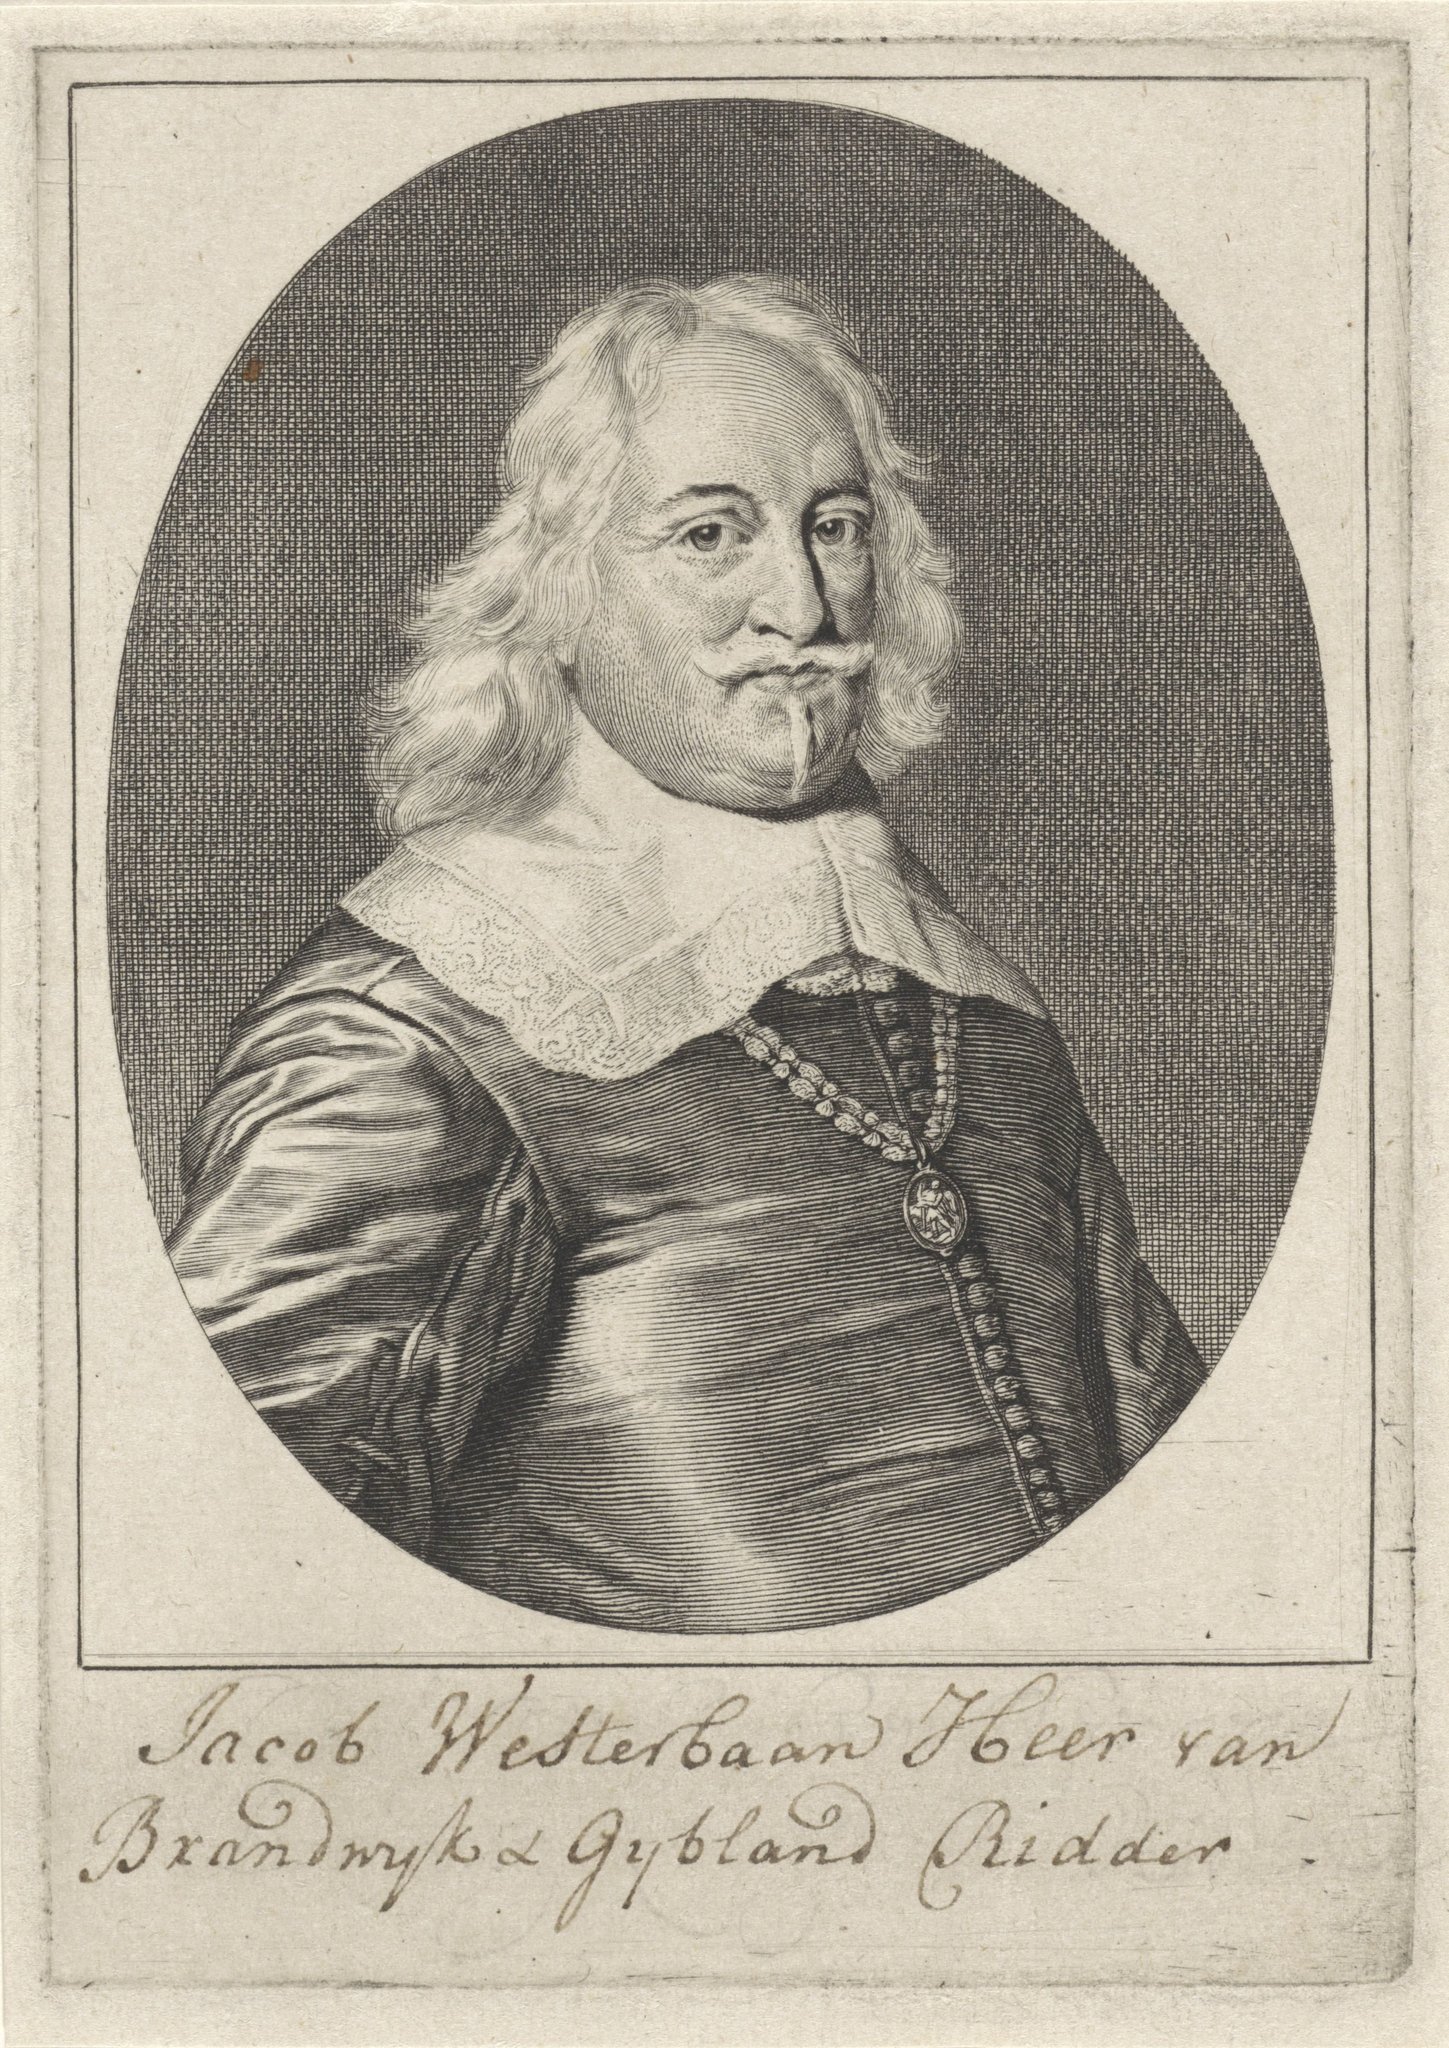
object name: print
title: Portret van Jacob Westerbaen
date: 1638-1658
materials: paper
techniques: engraving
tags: the hague, jacob westerbaen, pendant, trinket, 'breloque'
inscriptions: collector's mark: Lugt 240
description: Jacob Westerbaen, heer van Brantwyck-en-Ghybelant: Nederlandse ridder, dichter, arts en remonstrants predikant. Om zijn hals een keten waaraan een medaillion.